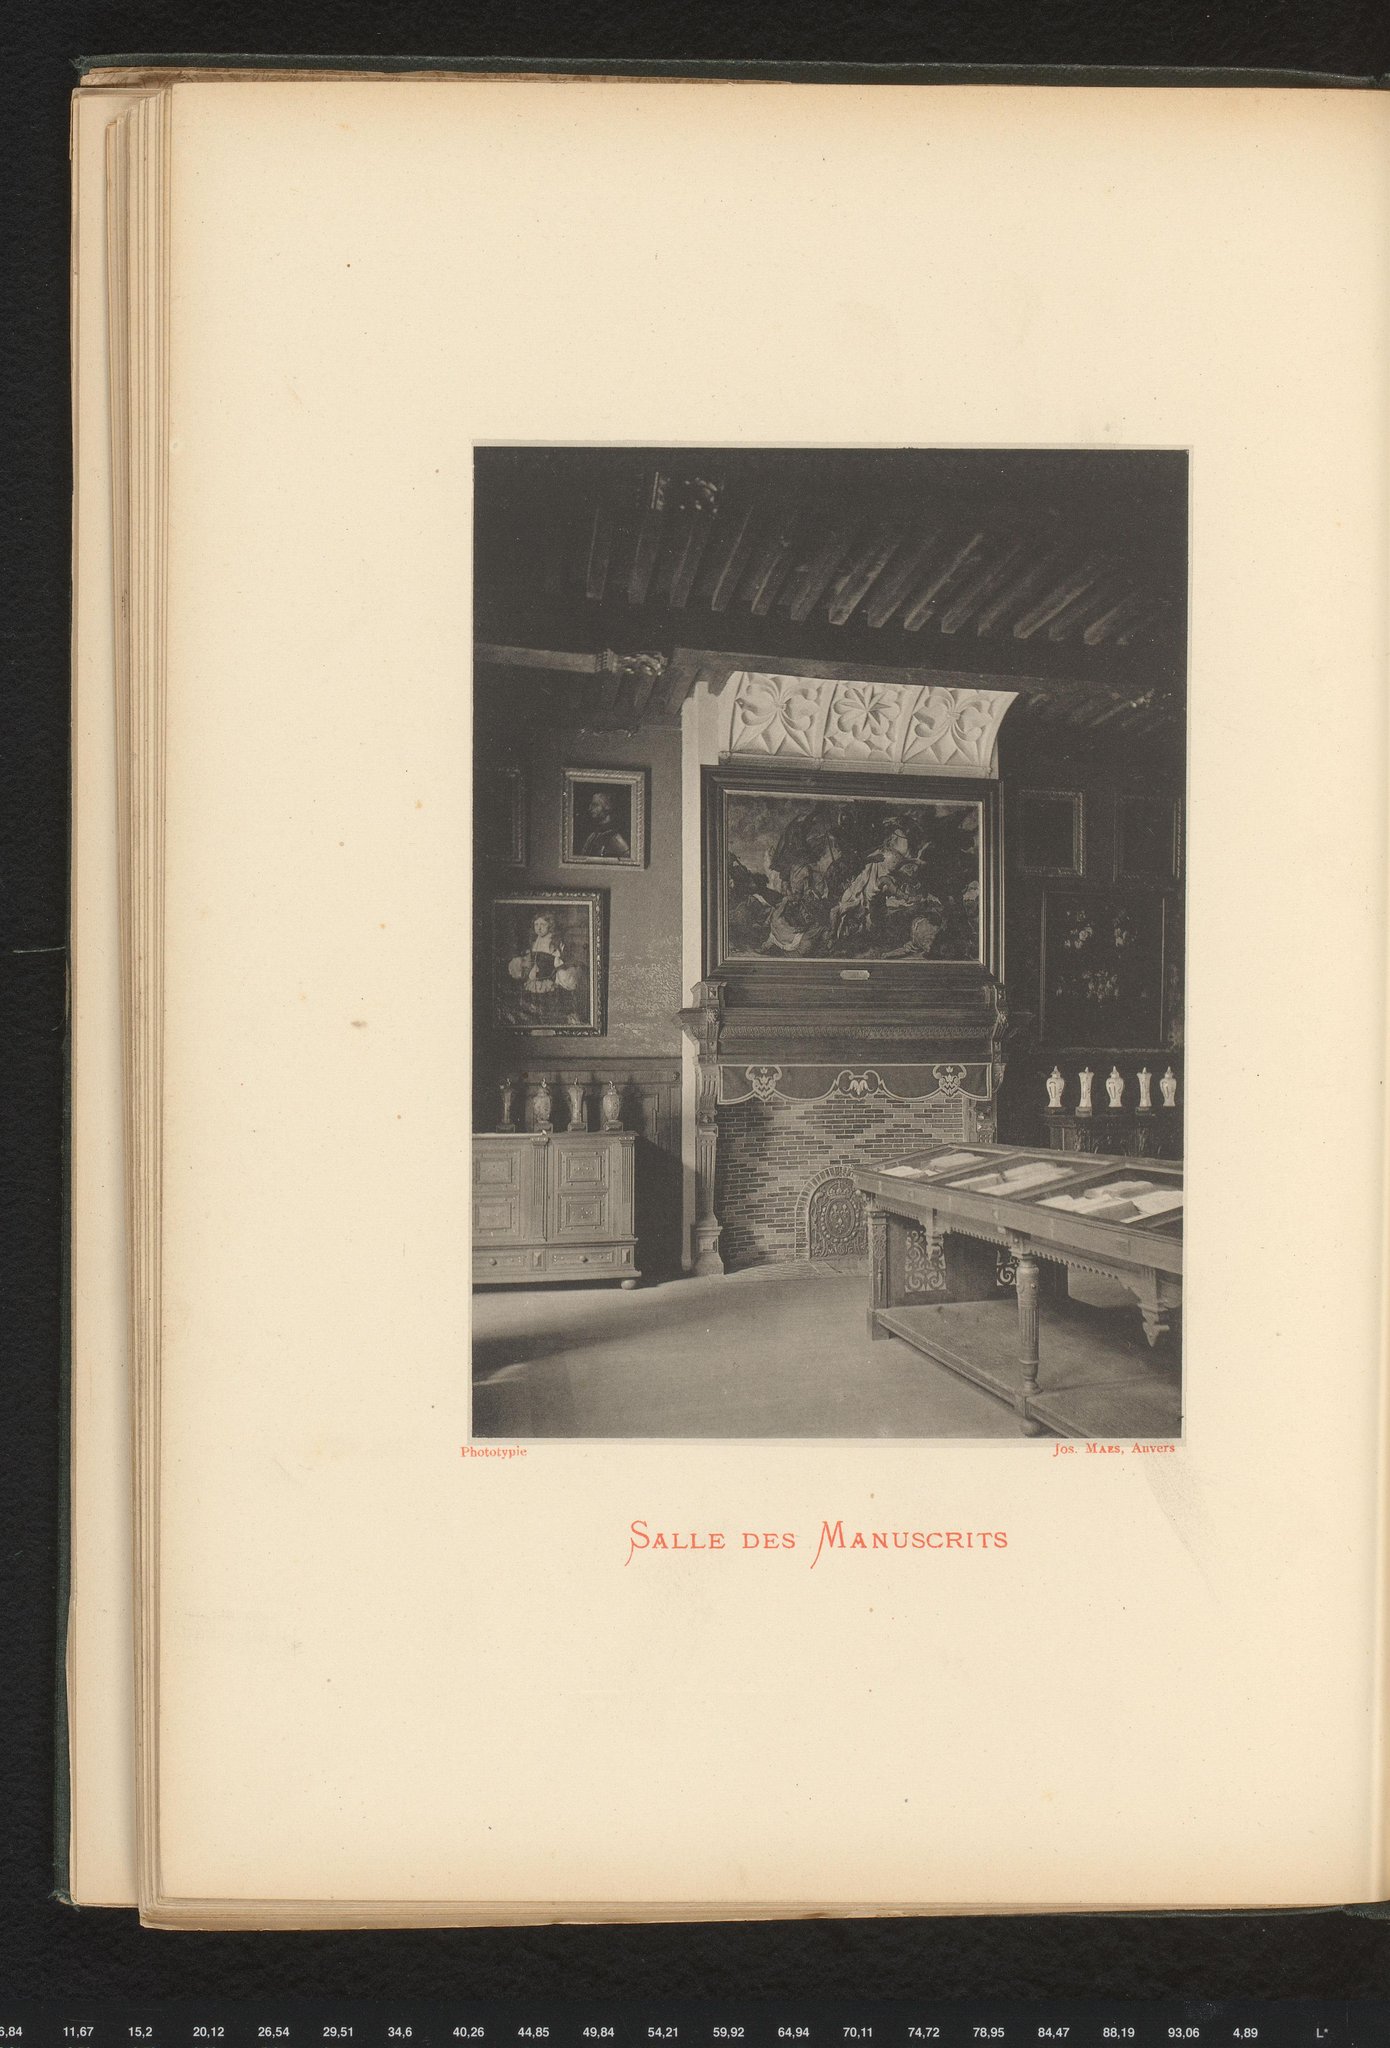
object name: photomechanical print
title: Kamer met manuscripten in het huis van Christoffel Plantijn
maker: joseph maes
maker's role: fotograaf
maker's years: 1838-1908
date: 1877-1882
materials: paper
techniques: photograph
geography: antwerp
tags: interior of the house